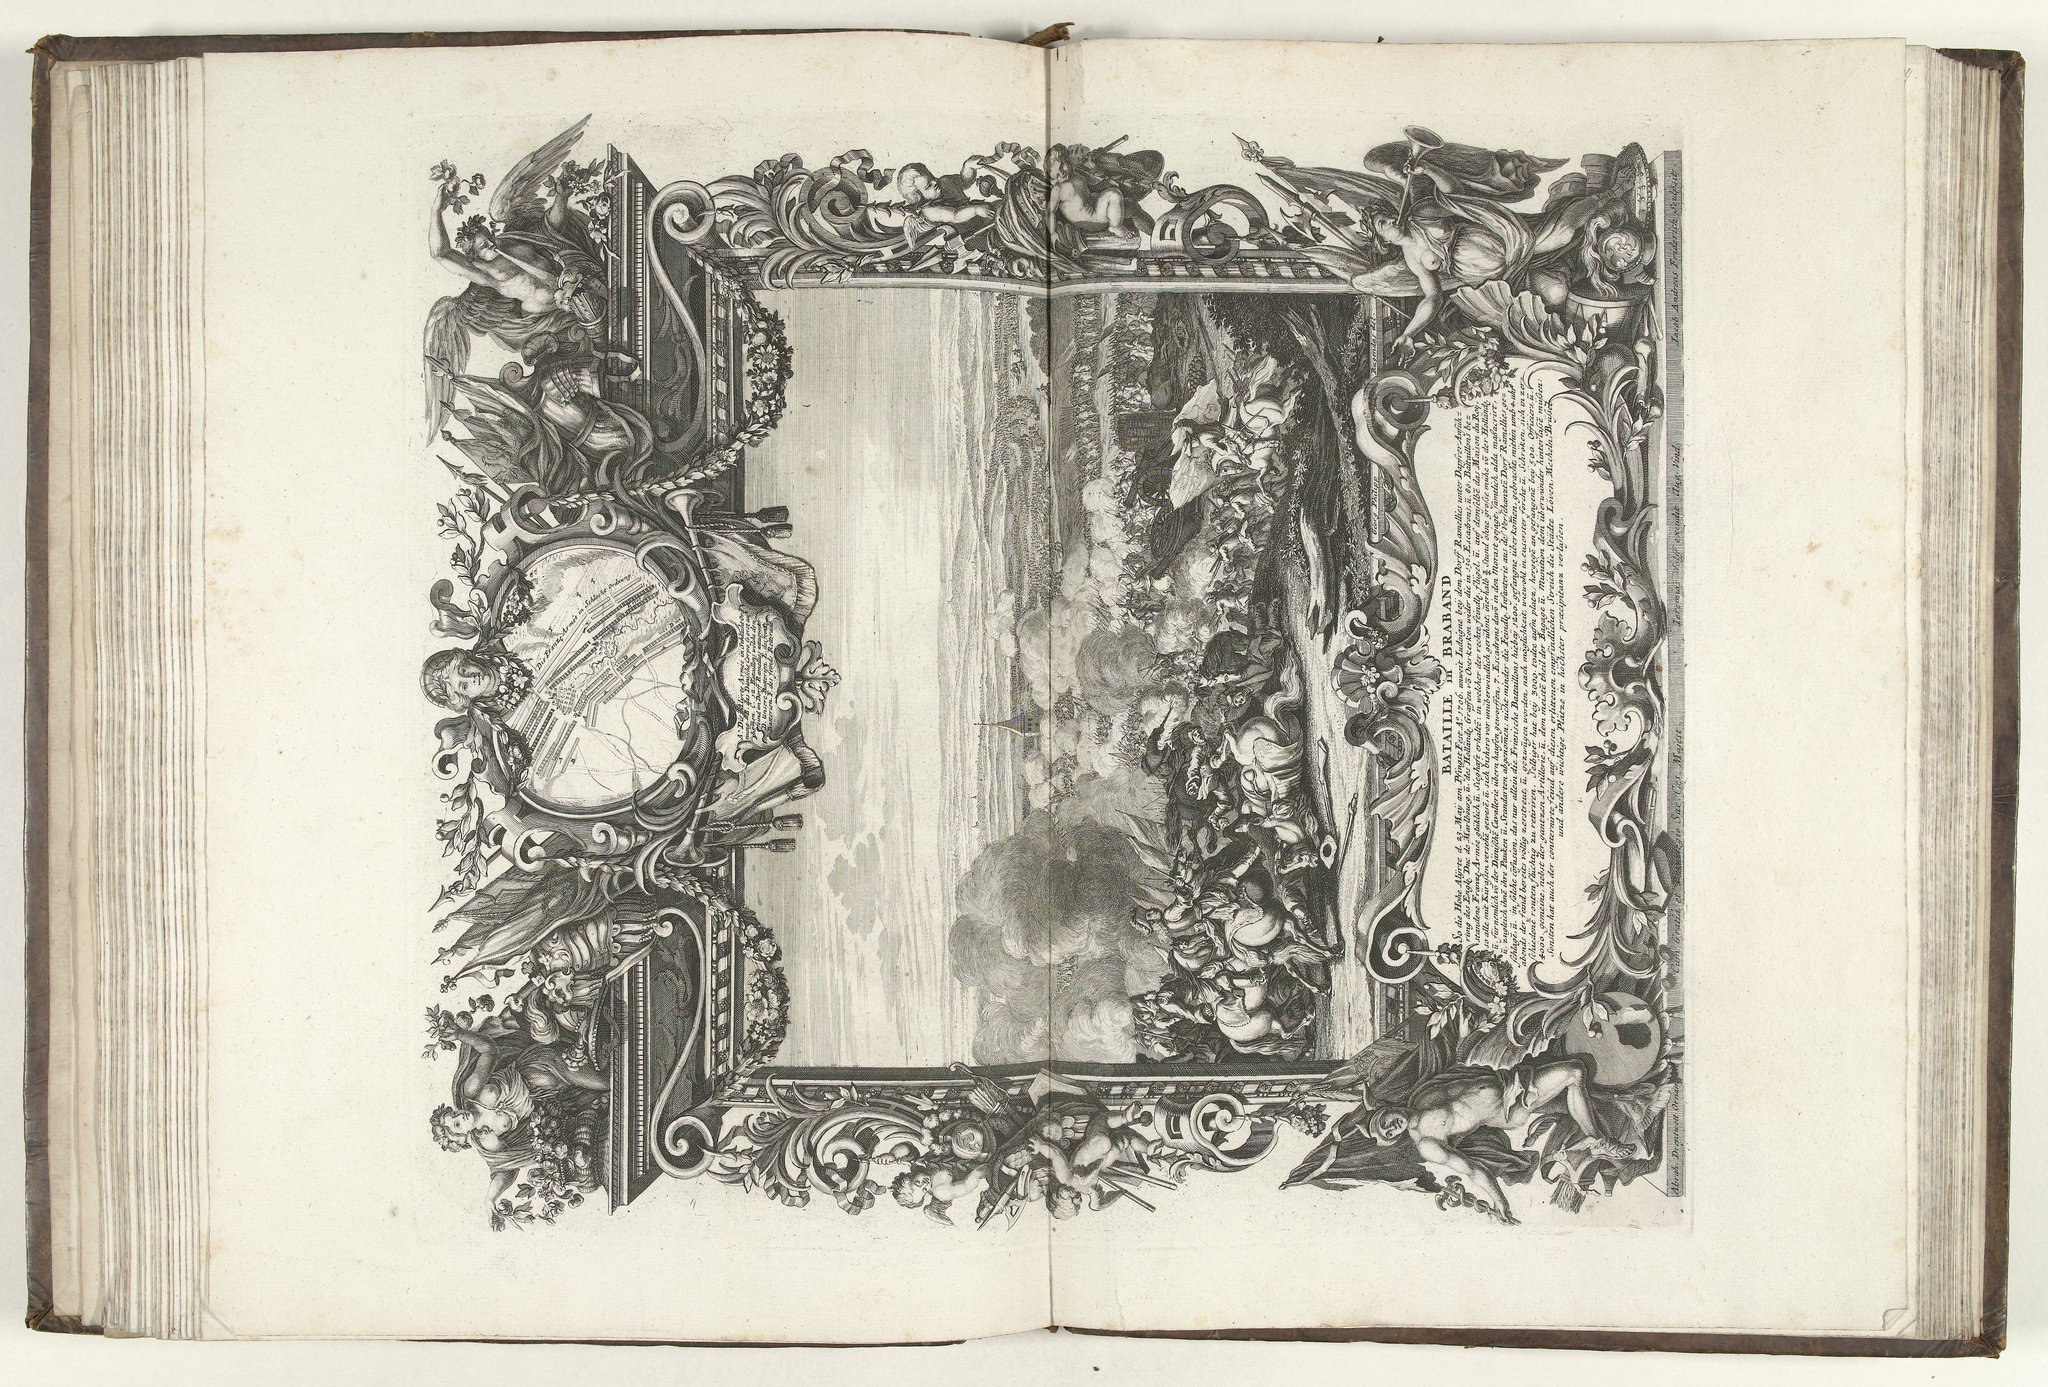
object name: history print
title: Bataille in Braband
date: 1712-1715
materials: paper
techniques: engraving, etching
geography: augsburg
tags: battle (+ land forces)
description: Slag bij Ramillies. Veldslag tussen de Fransen en de Geallieerden, 23 mei 1706. Voorstelling in een rijk versierde ornamentele omlijsting met bovenaan een cartouche met een plattegrond van de slag. Onderaan een cartouche met de beschrijving van de strijd in het Duits. Links Mercurius, rechts de Faam. Blad in de gebonden verzameling platen uitgebracht onder de titel: Repraesentatio belli ... Der Spanische Successions-Krieg [ca. 1720].